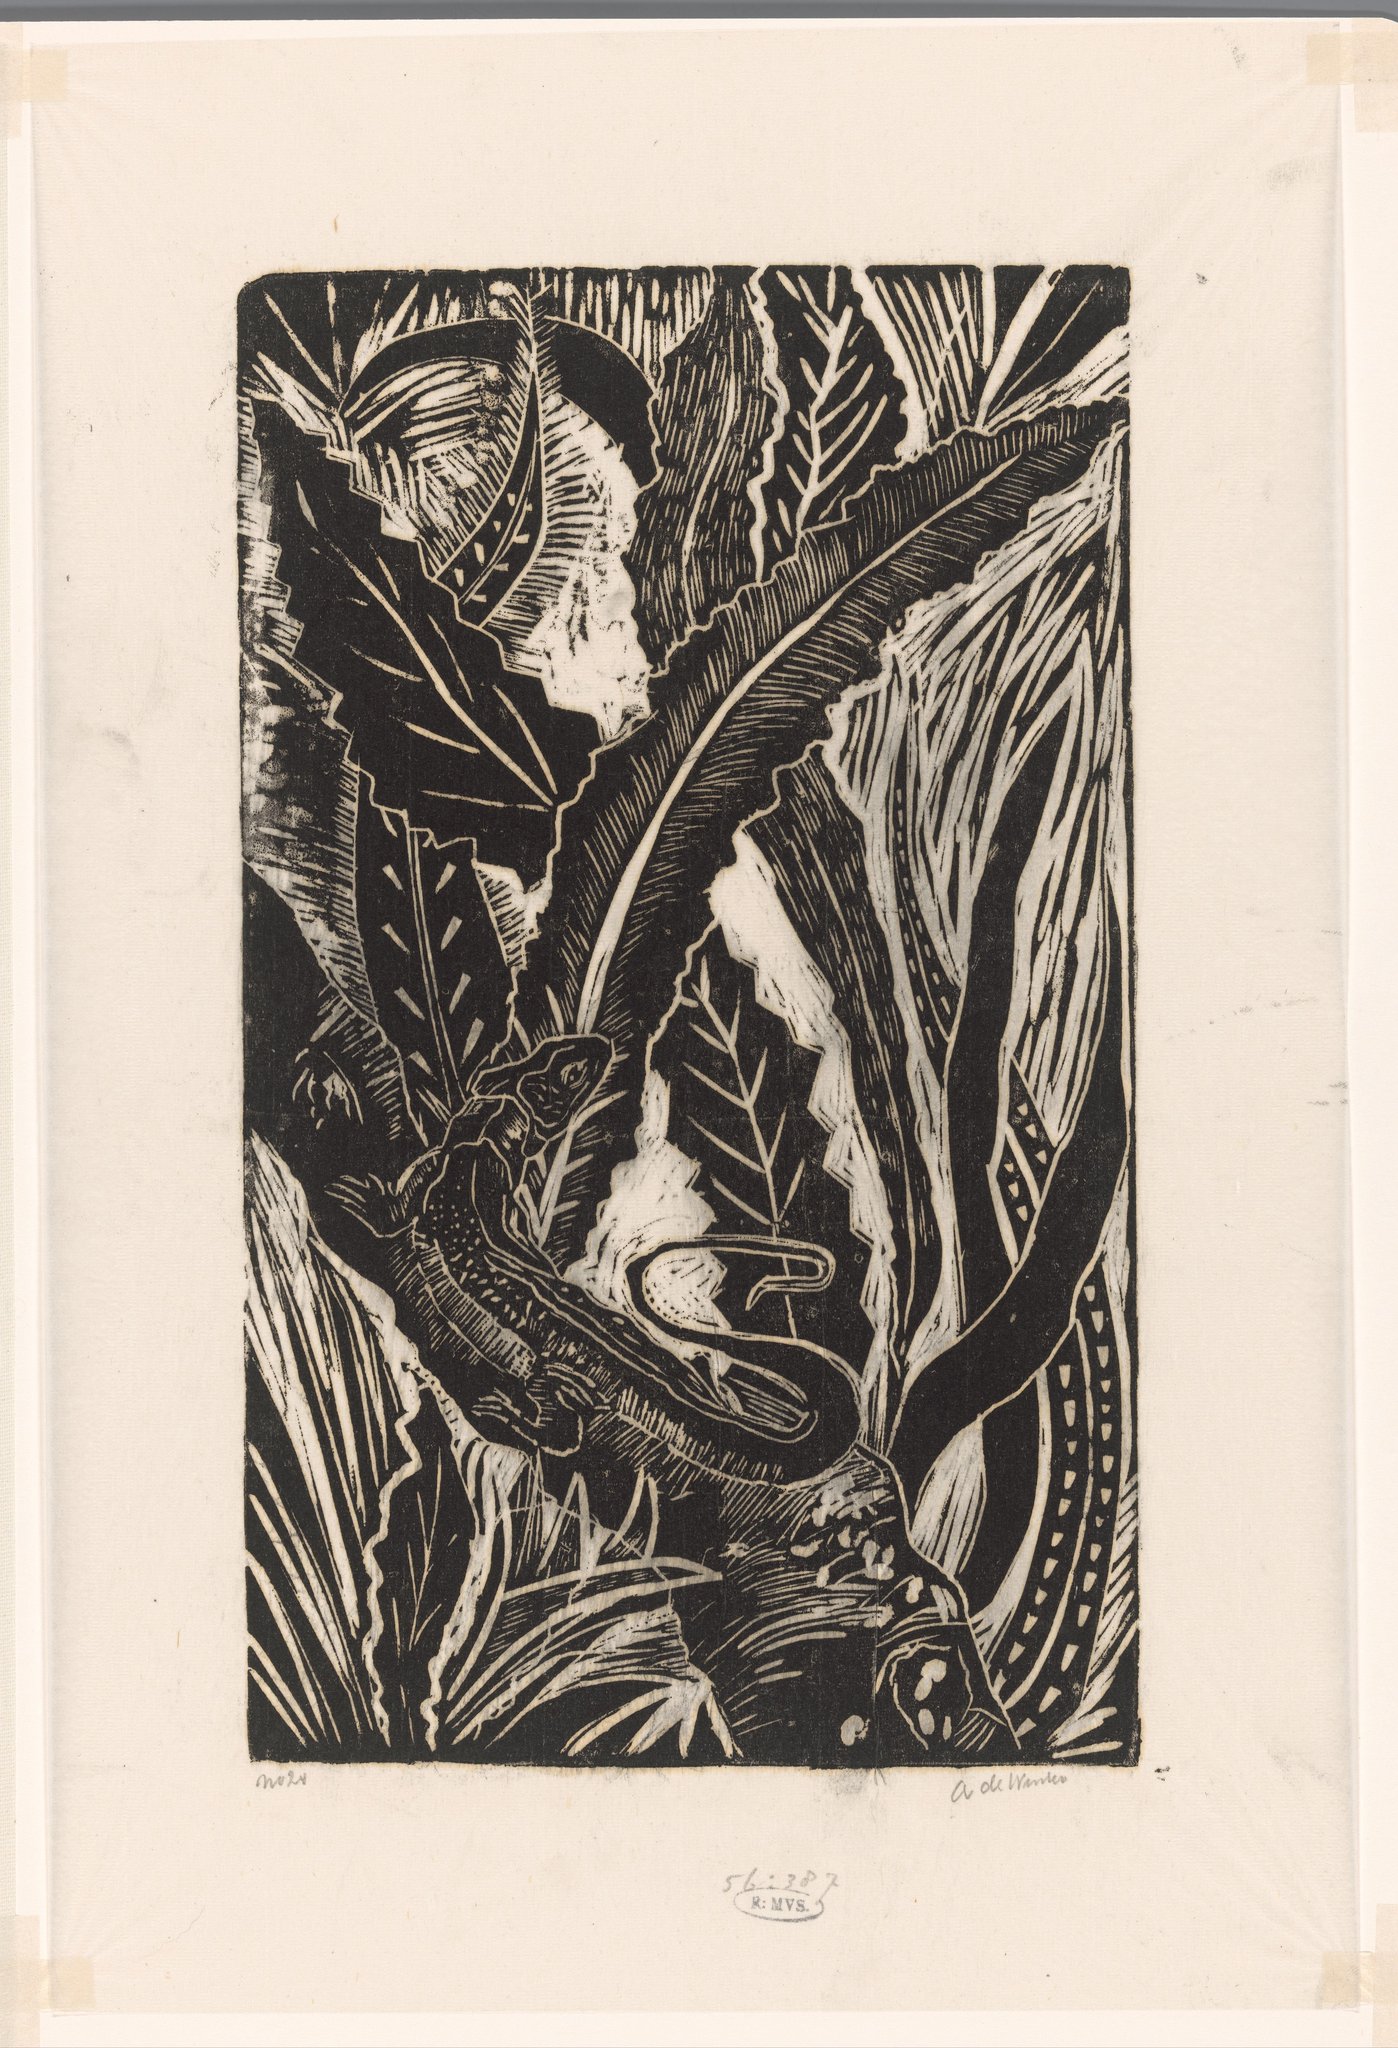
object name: print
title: Hagedis op een boomstam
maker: janus de winter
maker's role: print maker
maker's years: 1882-1951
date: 1892-1951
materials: paper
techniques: linocut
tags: lizards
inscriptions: collector's mark: Lugt 2228